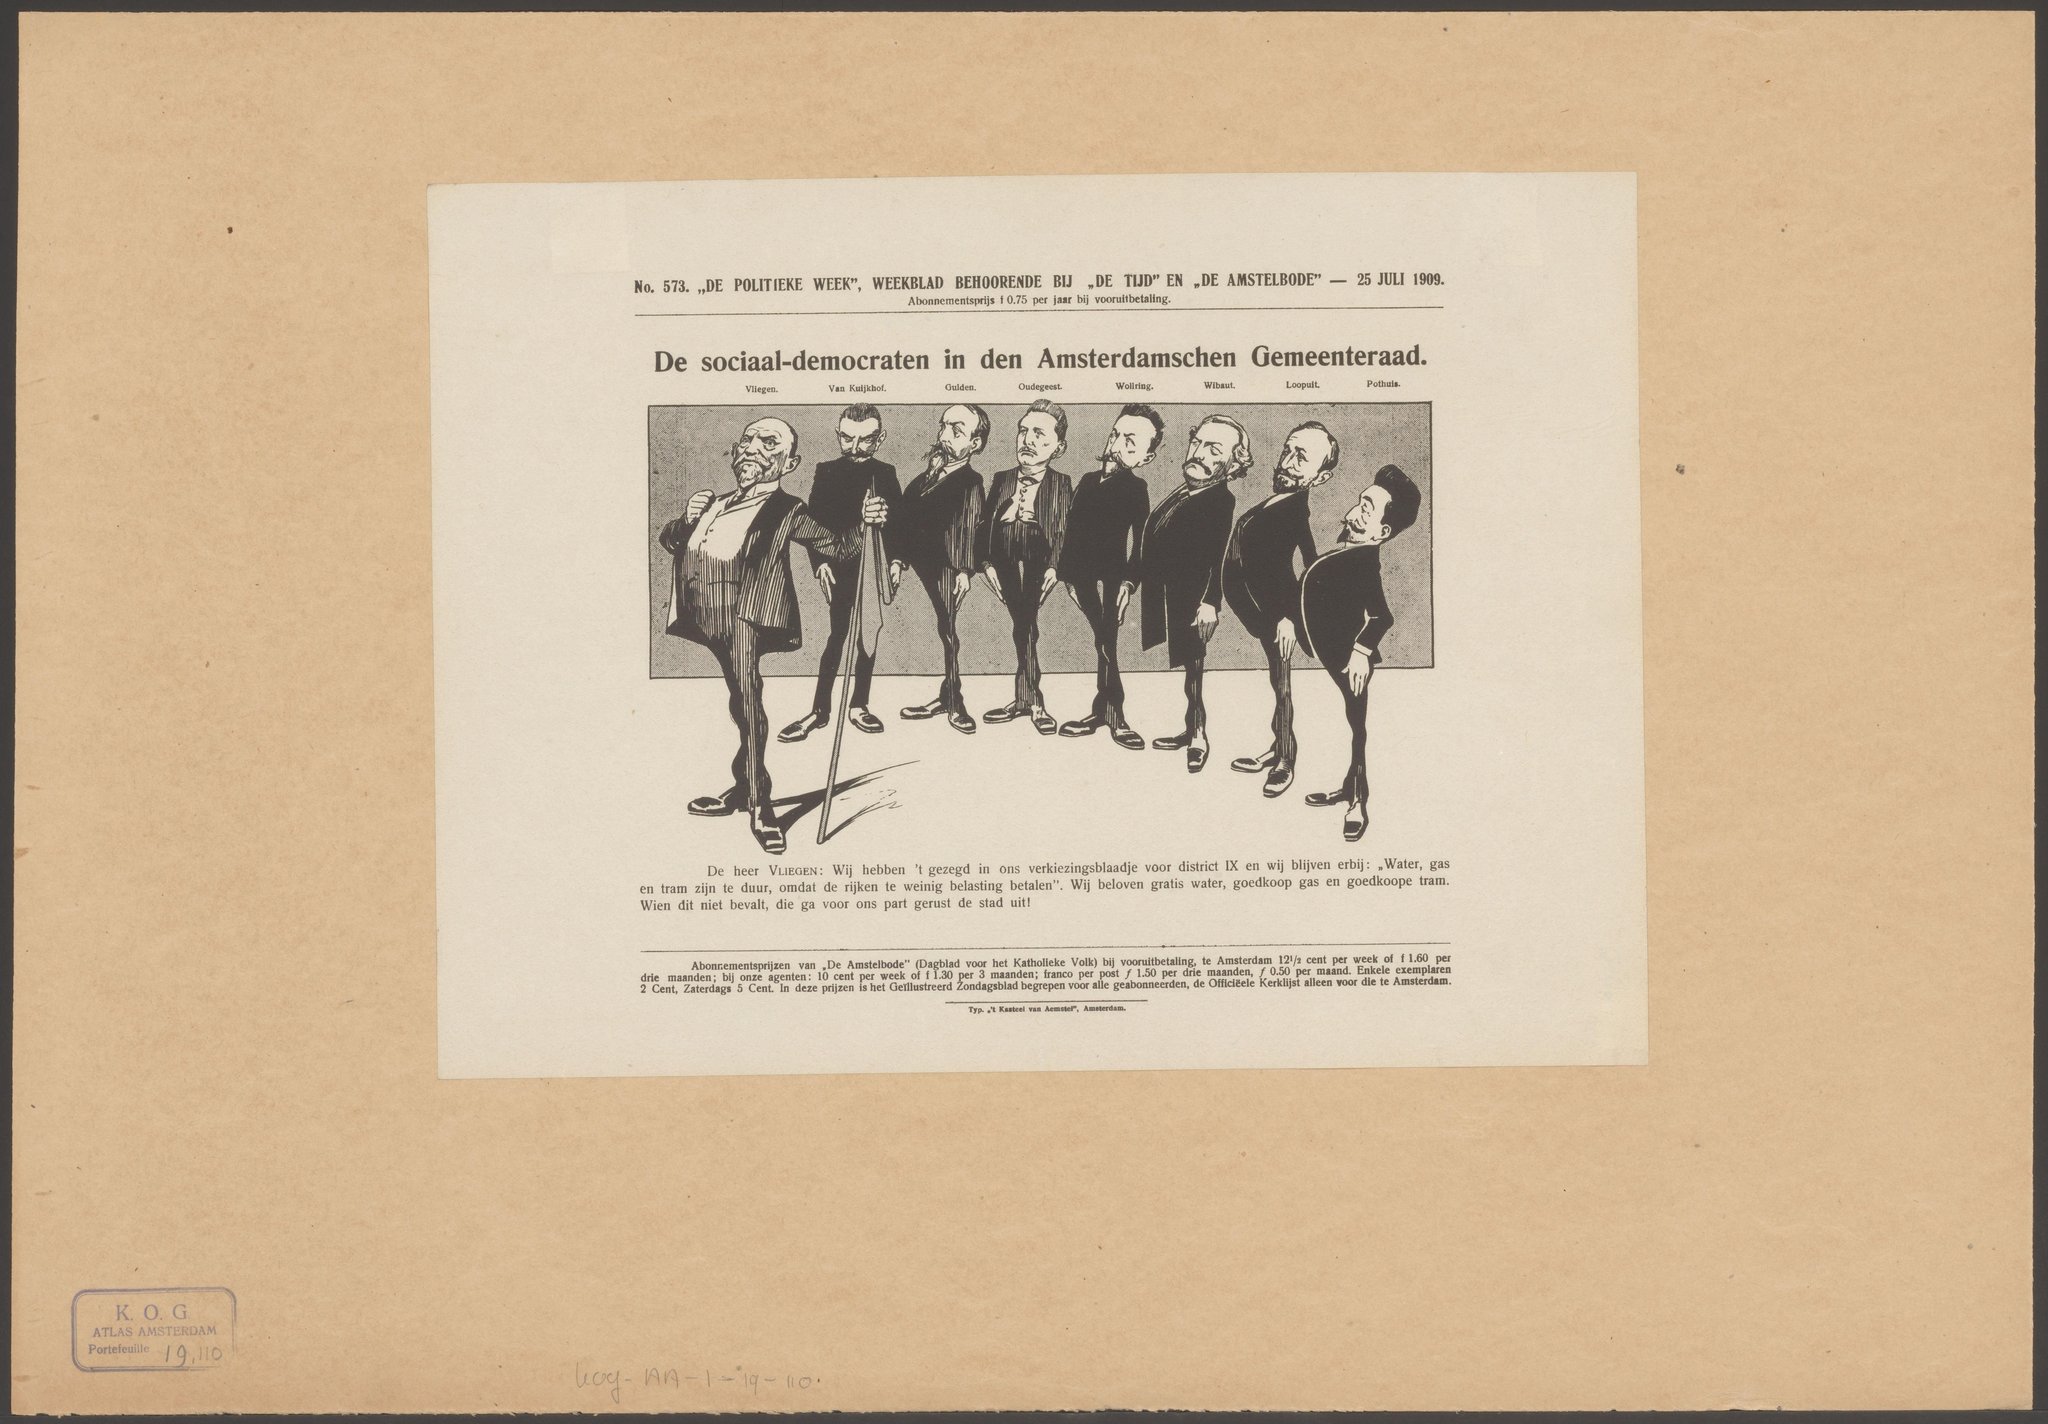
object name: cartoon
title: De sociaal-democraten in den Amsterdamschen Gemeenteraad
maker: Anonymous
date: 1909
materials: paper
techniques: letterpress printing, line block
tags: city council, political caricatures and satires, amsterdam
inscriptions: collector's mark: ‘19,110’ Lugt 1641b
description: Onderwerpsrubriek binnen de Atlas Amsterdam: Herinneringen aan regeringsleden en hunne huisgezinnen [na 1800].